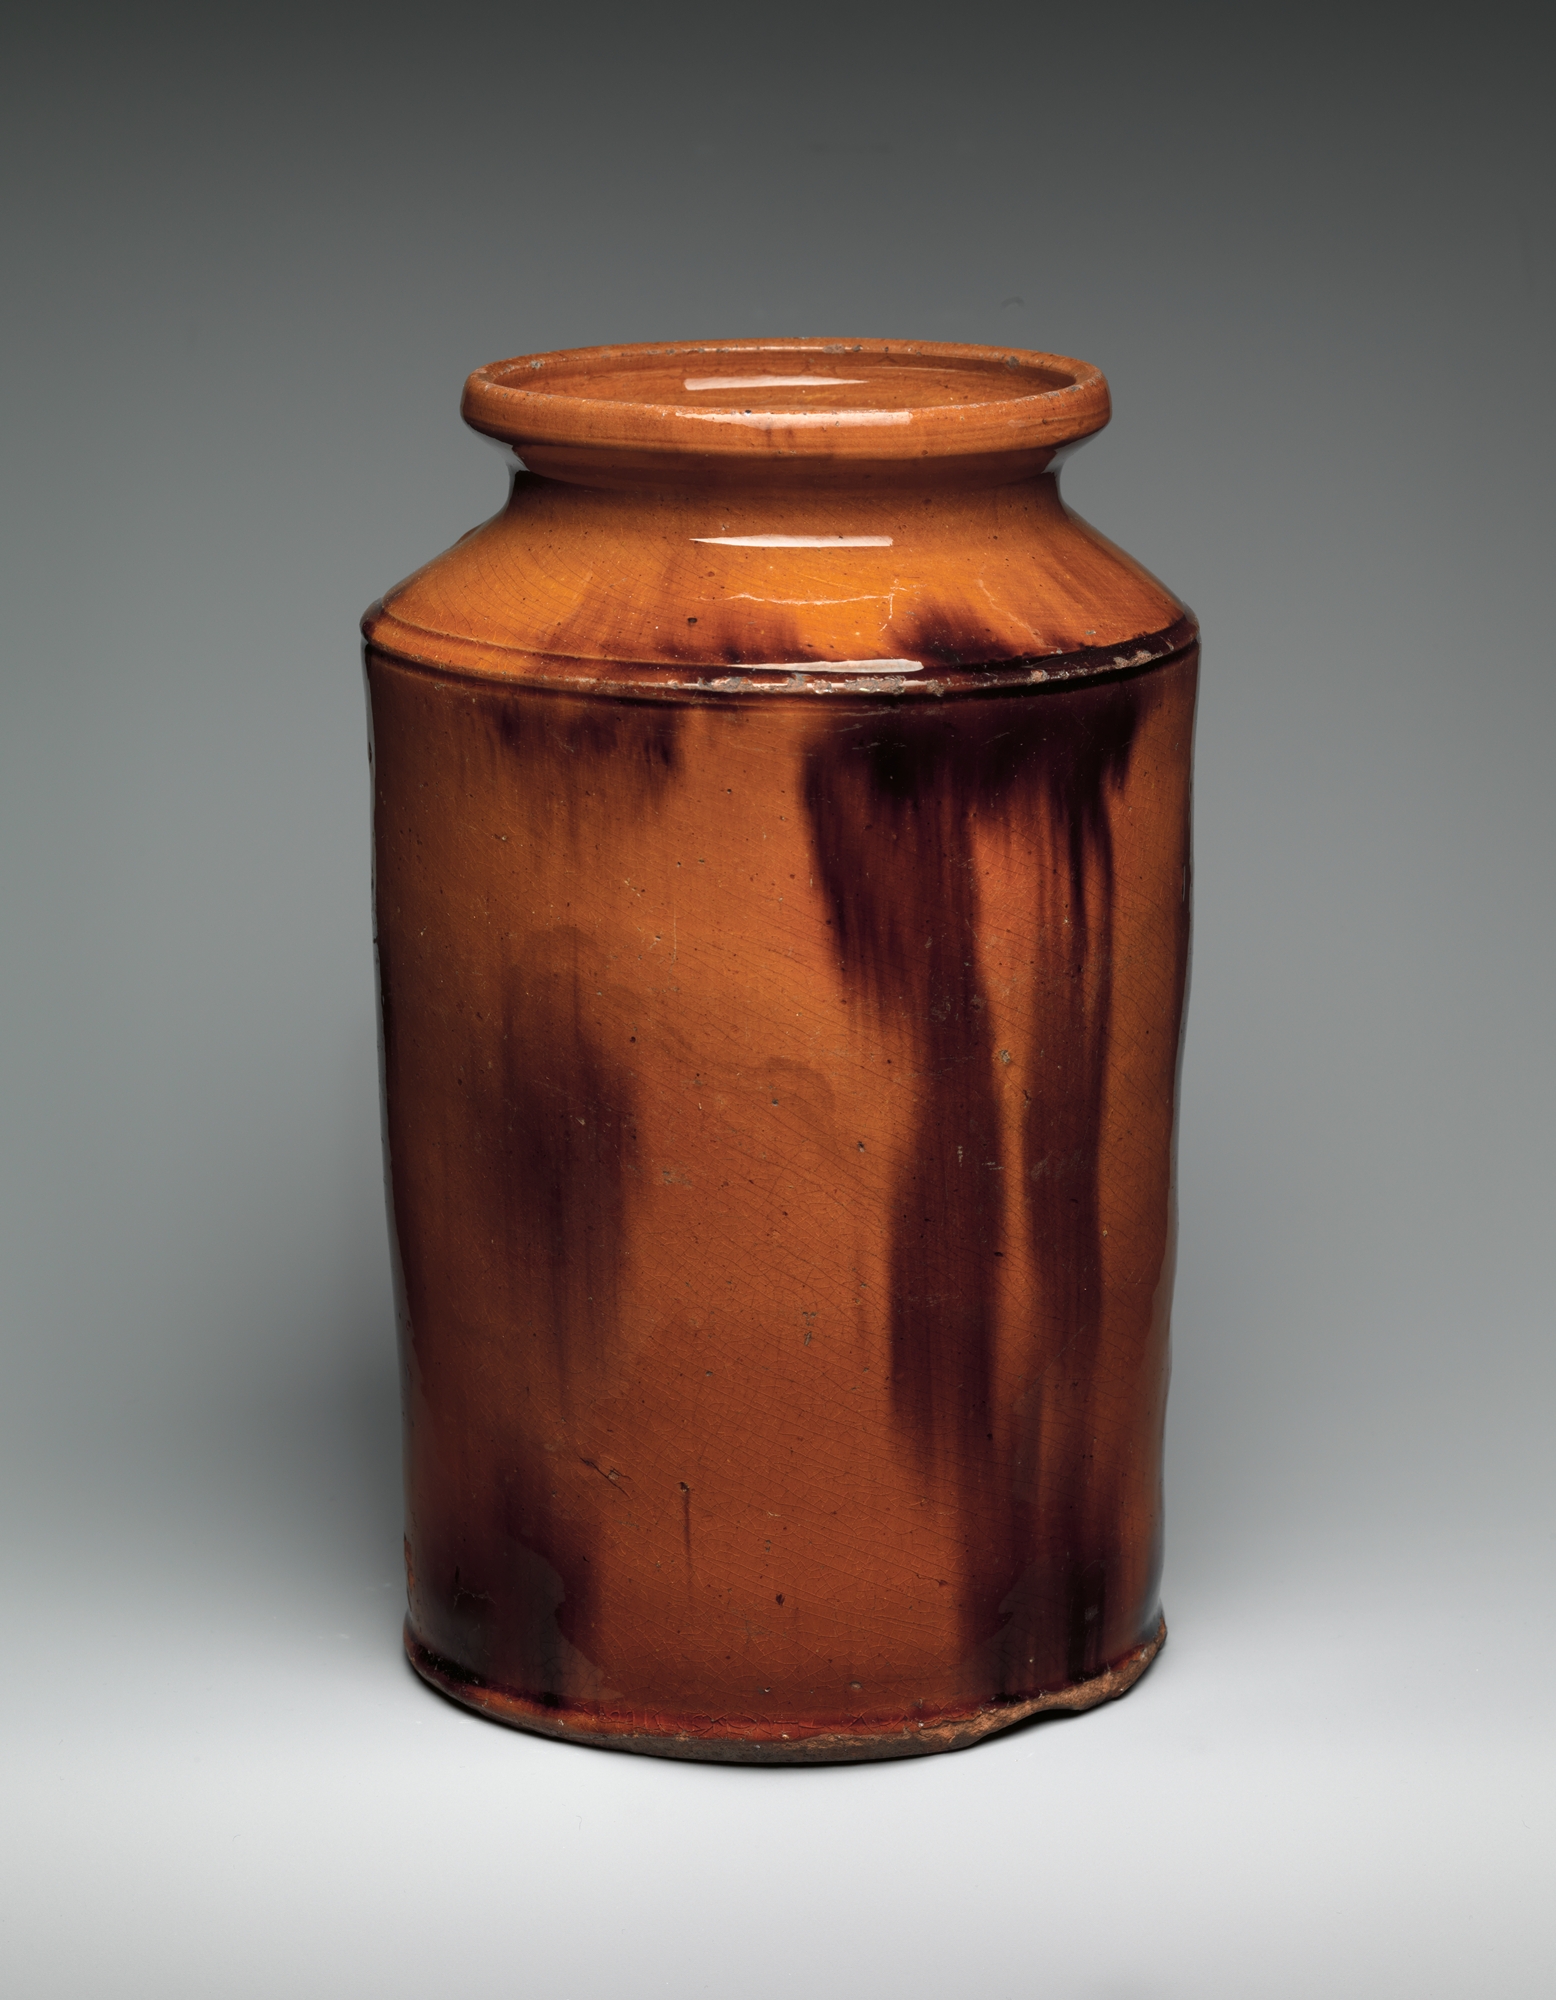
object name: jar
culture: american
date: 1800-1900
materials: earthenware